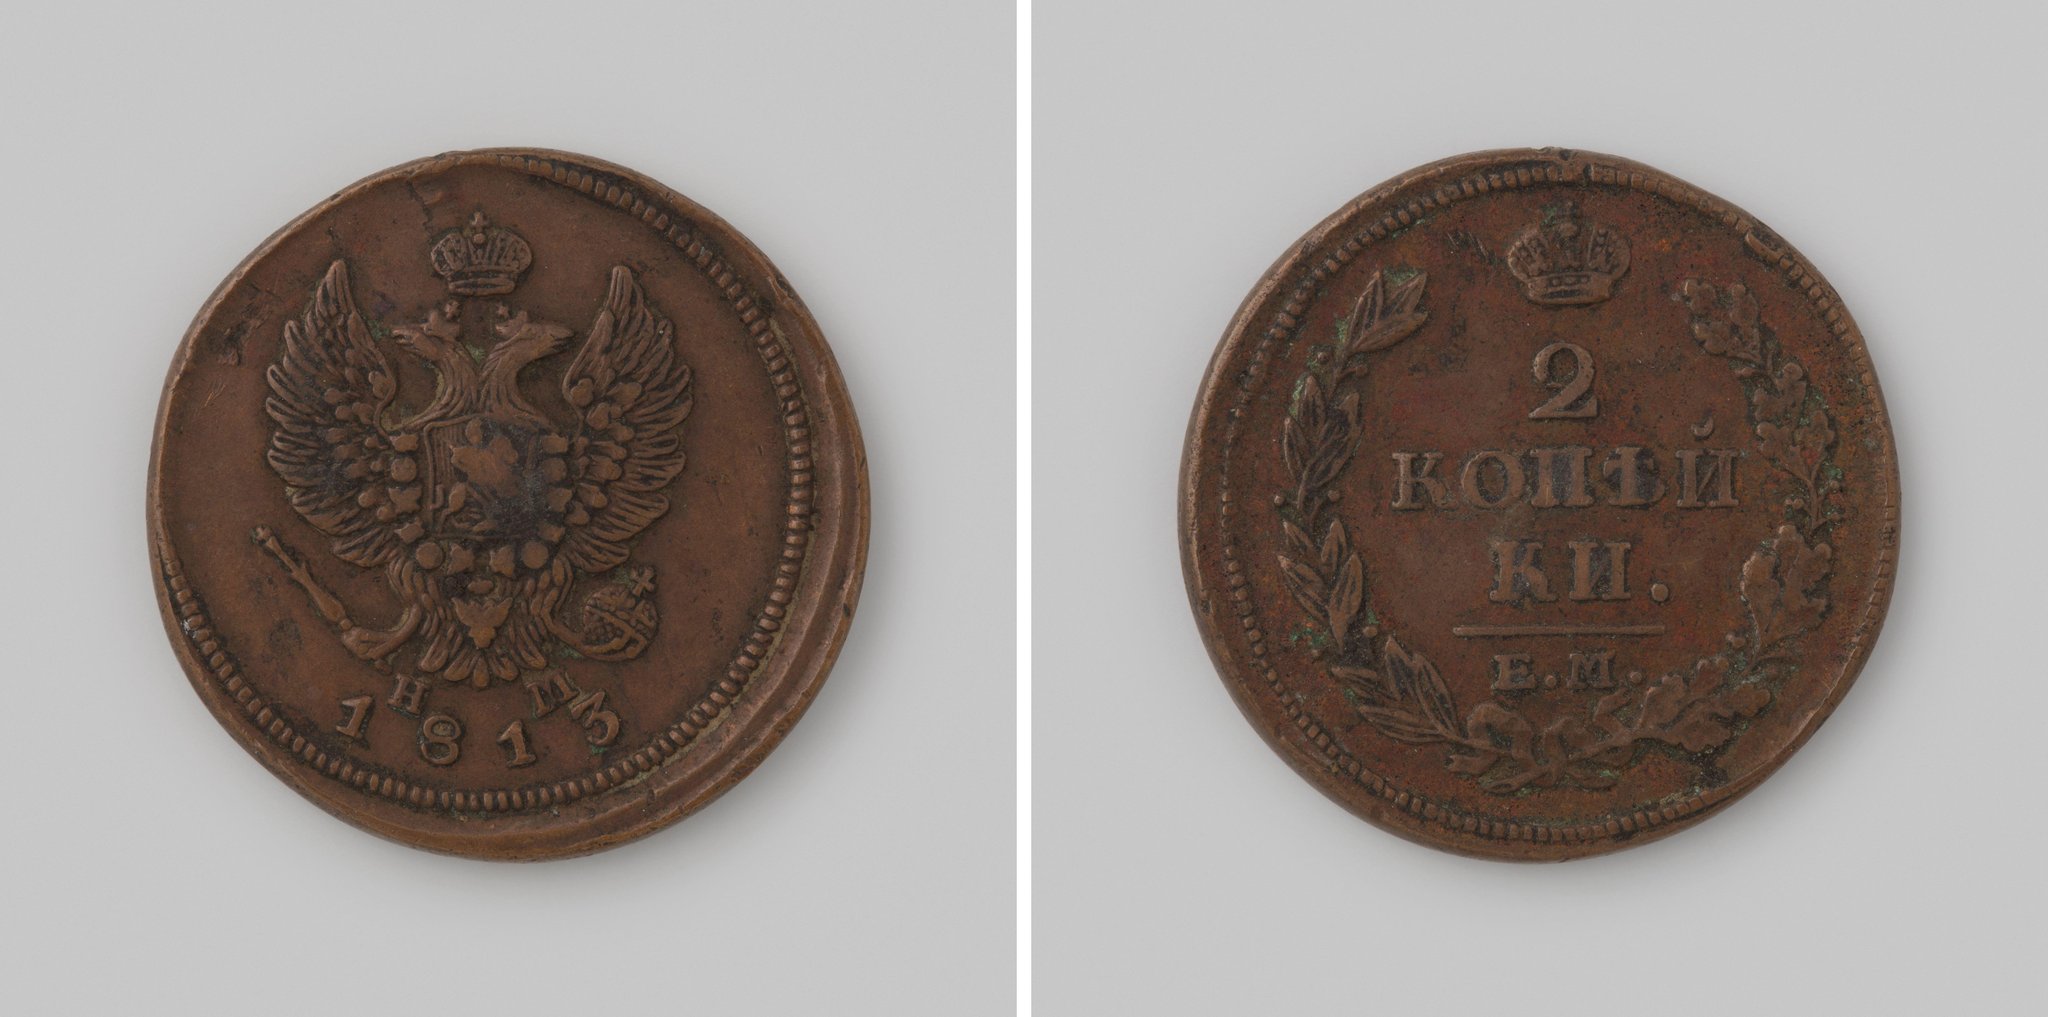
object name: coin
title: Rusland, tsaar Alexander I, 2 kopeken, 1813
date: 1813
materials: copper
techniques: striking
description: Koperen munt. Voorzijde: dubbelkoppige gekroonde adelaar met gespreide vleugels, met op zijn borst door ridderorde omhangen wapenschild en met in zijn poten scepter en bol met daarop kruis. Boven de adelaar een kroon. Jaartal onderaan. Keerzijde: binnen twee samengebonden takken onder een kroon waarde-aanduiding in twee regels. Daaronder de letters E M [=ekaterinenburg]. Gladde rand.